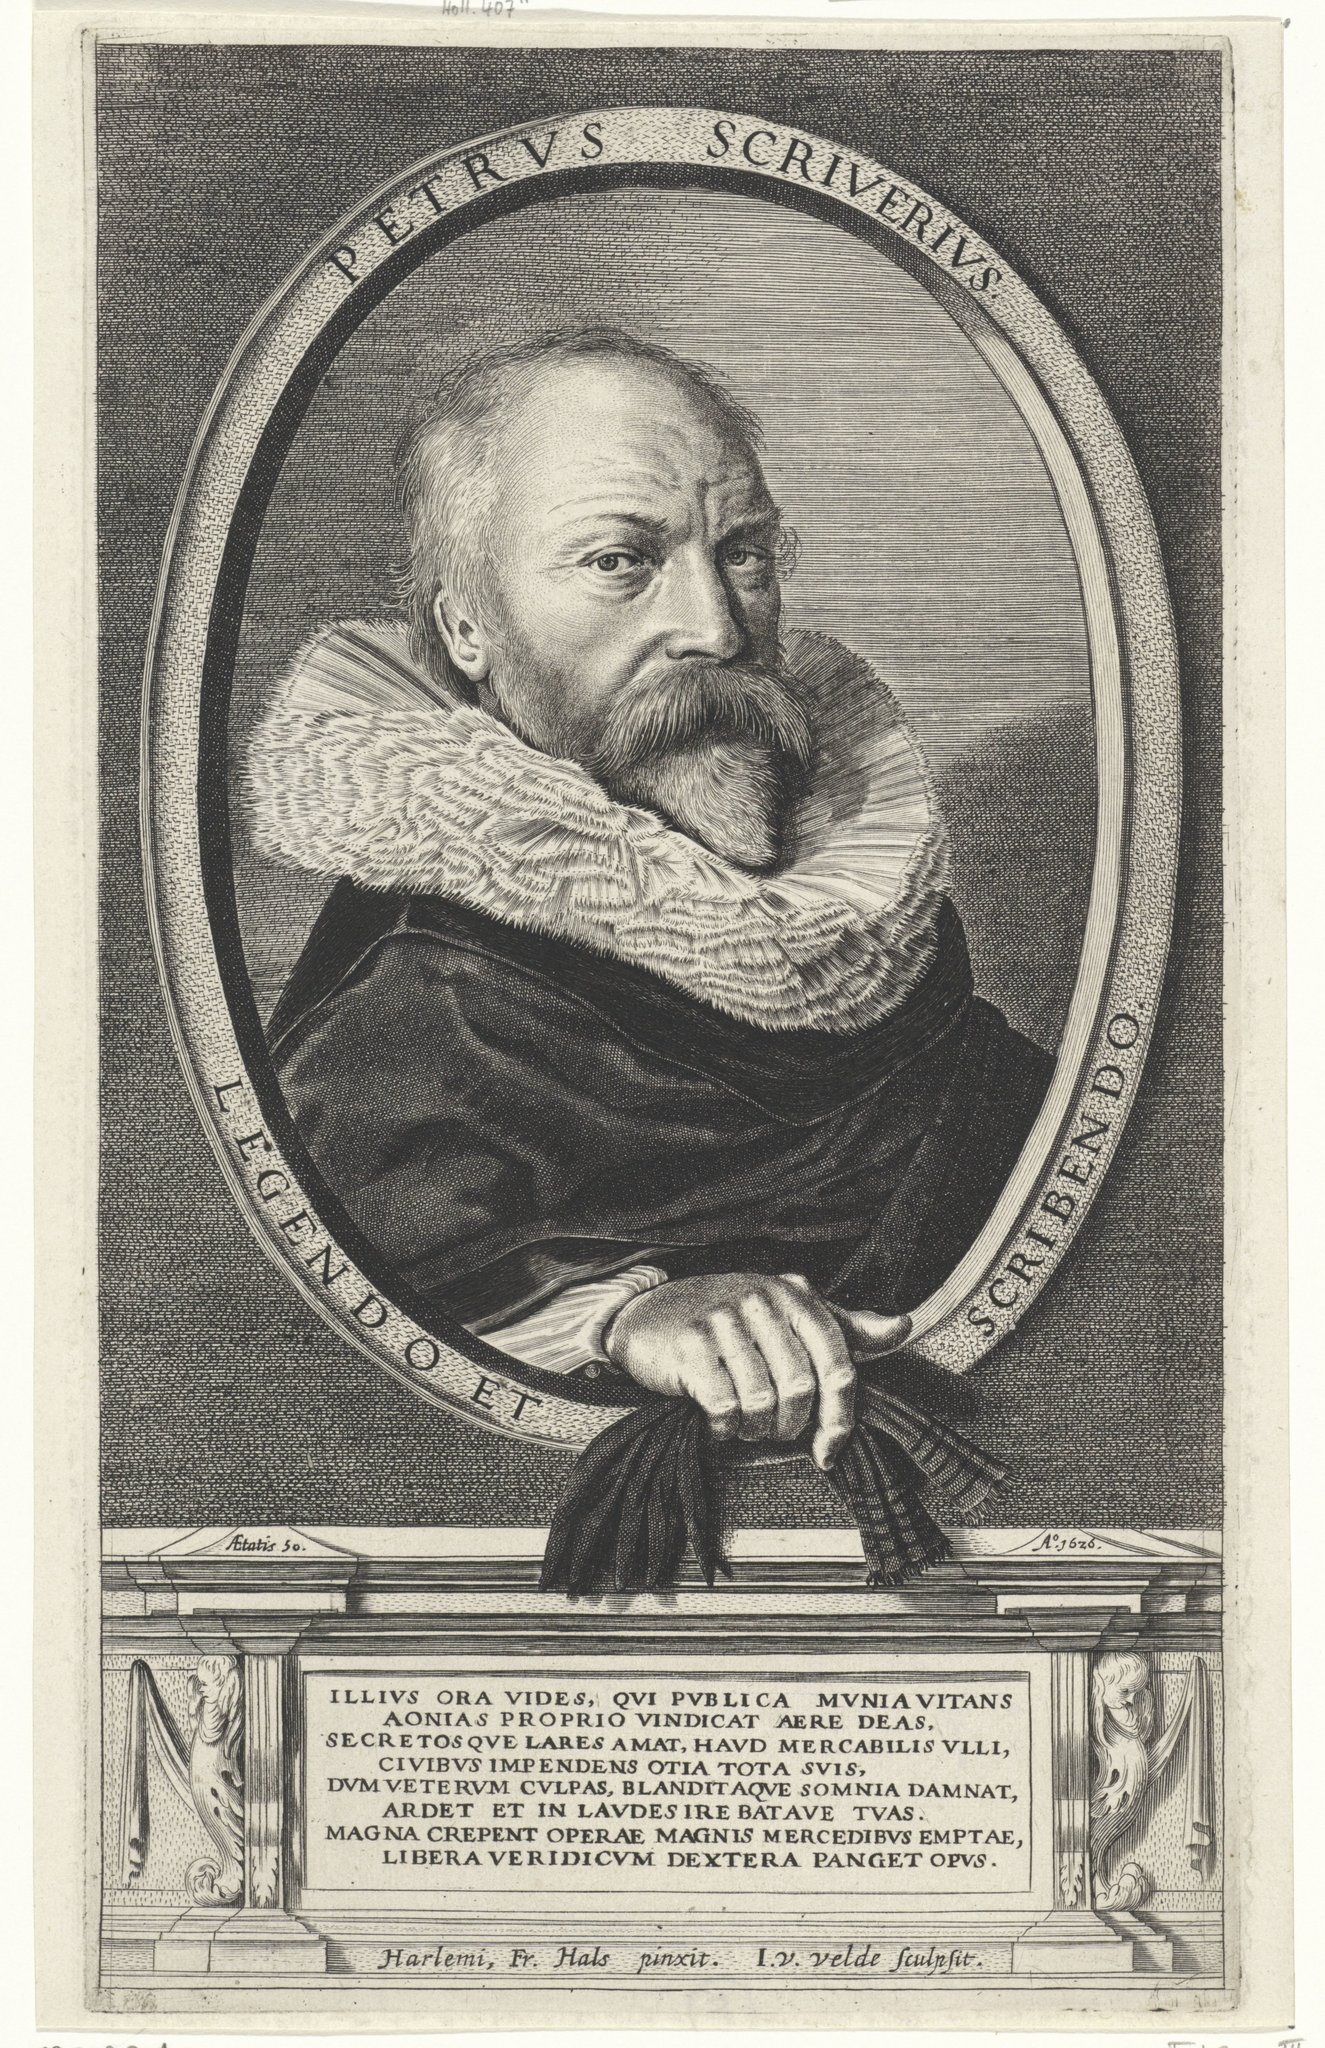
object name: print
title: Portret van Petrus Scriverius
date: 1626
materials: paper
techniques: engraving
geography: northern netherlands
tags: petrus scriverius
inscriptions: collector's mark: Lugt 964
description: Portret van de geschiedkundige en schrijver Petrus Scriverius op 50-jarige leeftijd.